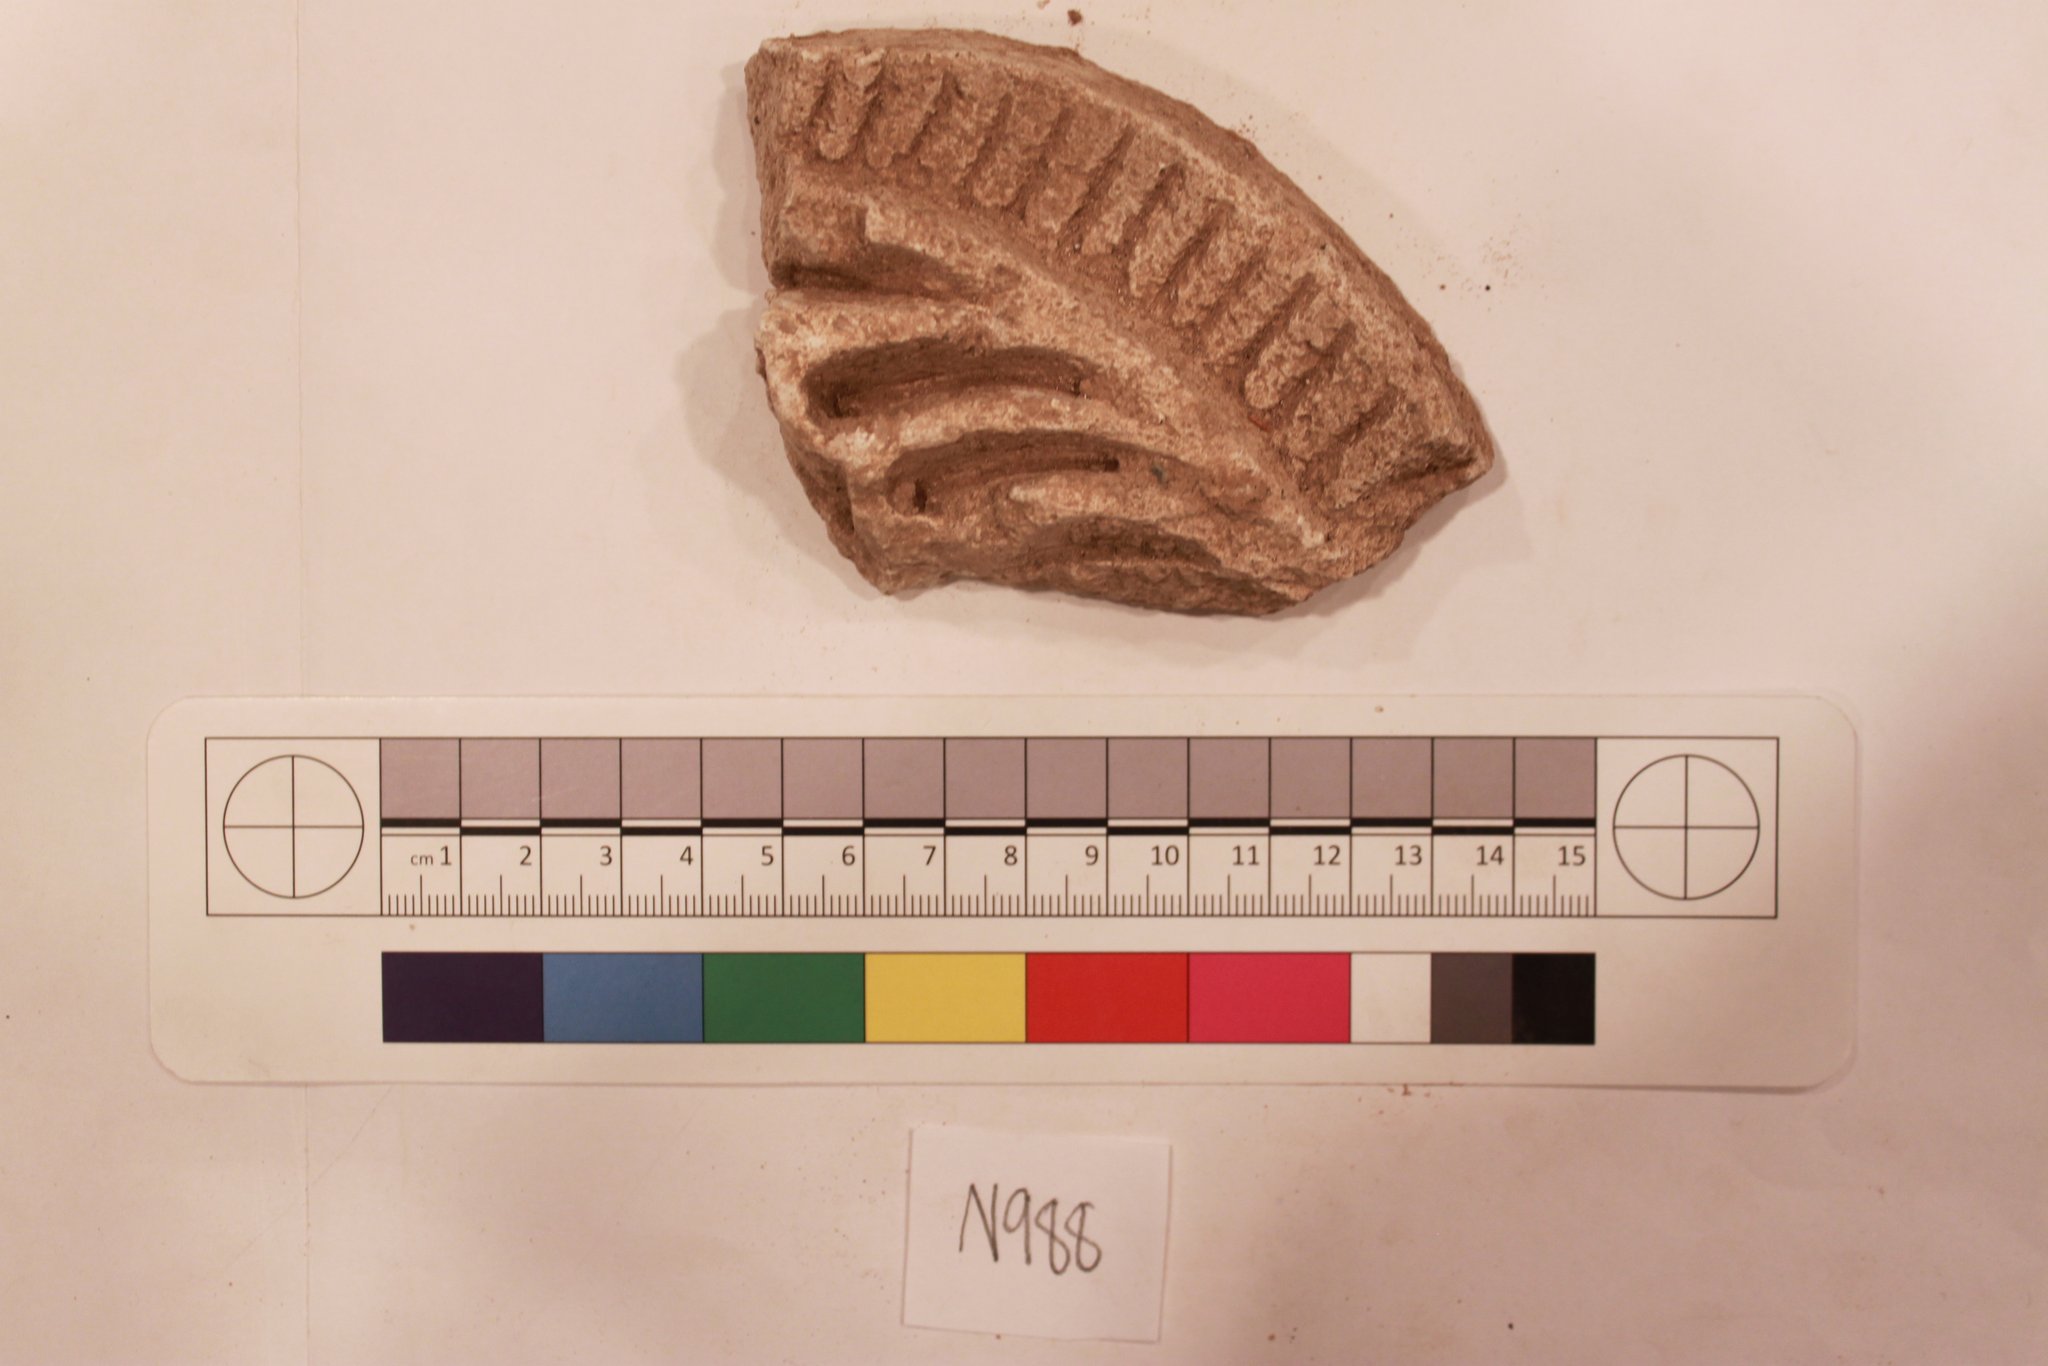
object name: fragment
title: Stucco Fragment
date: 701-1200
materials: plaster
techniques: carving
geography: iran